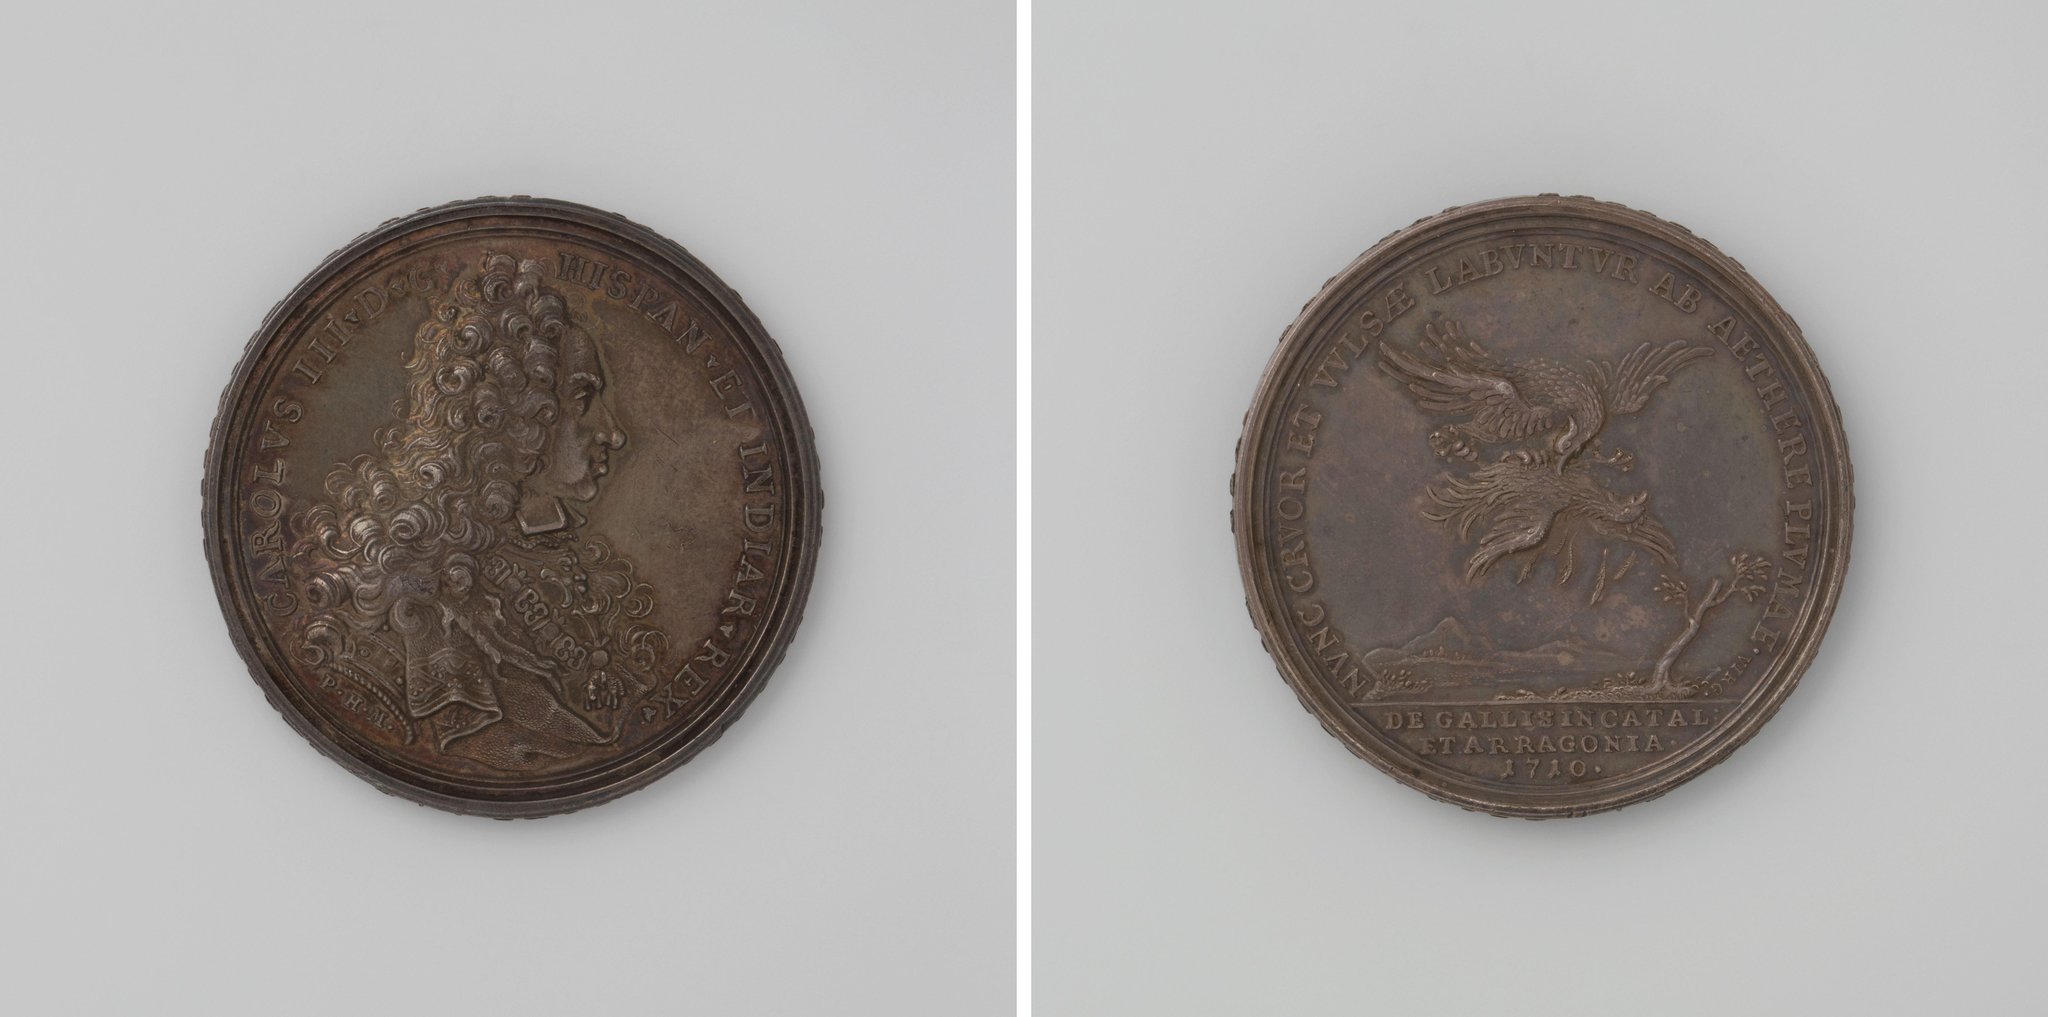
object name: history medal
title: Slag bij Zaragossa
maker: philipp heinrich müller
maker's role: medailleur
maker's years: 1654-1719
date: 1710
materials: silver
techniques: striking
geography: nuremberg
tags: vienna, charles vi (holy roman emperor)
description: Zilveren penning. Voorzijde: borststuk man binnen omschrift. Keerzijde: vliegende Rijksadelaar in gevecht met Franse haan binnen omschrift, boven opschrift; randschrift